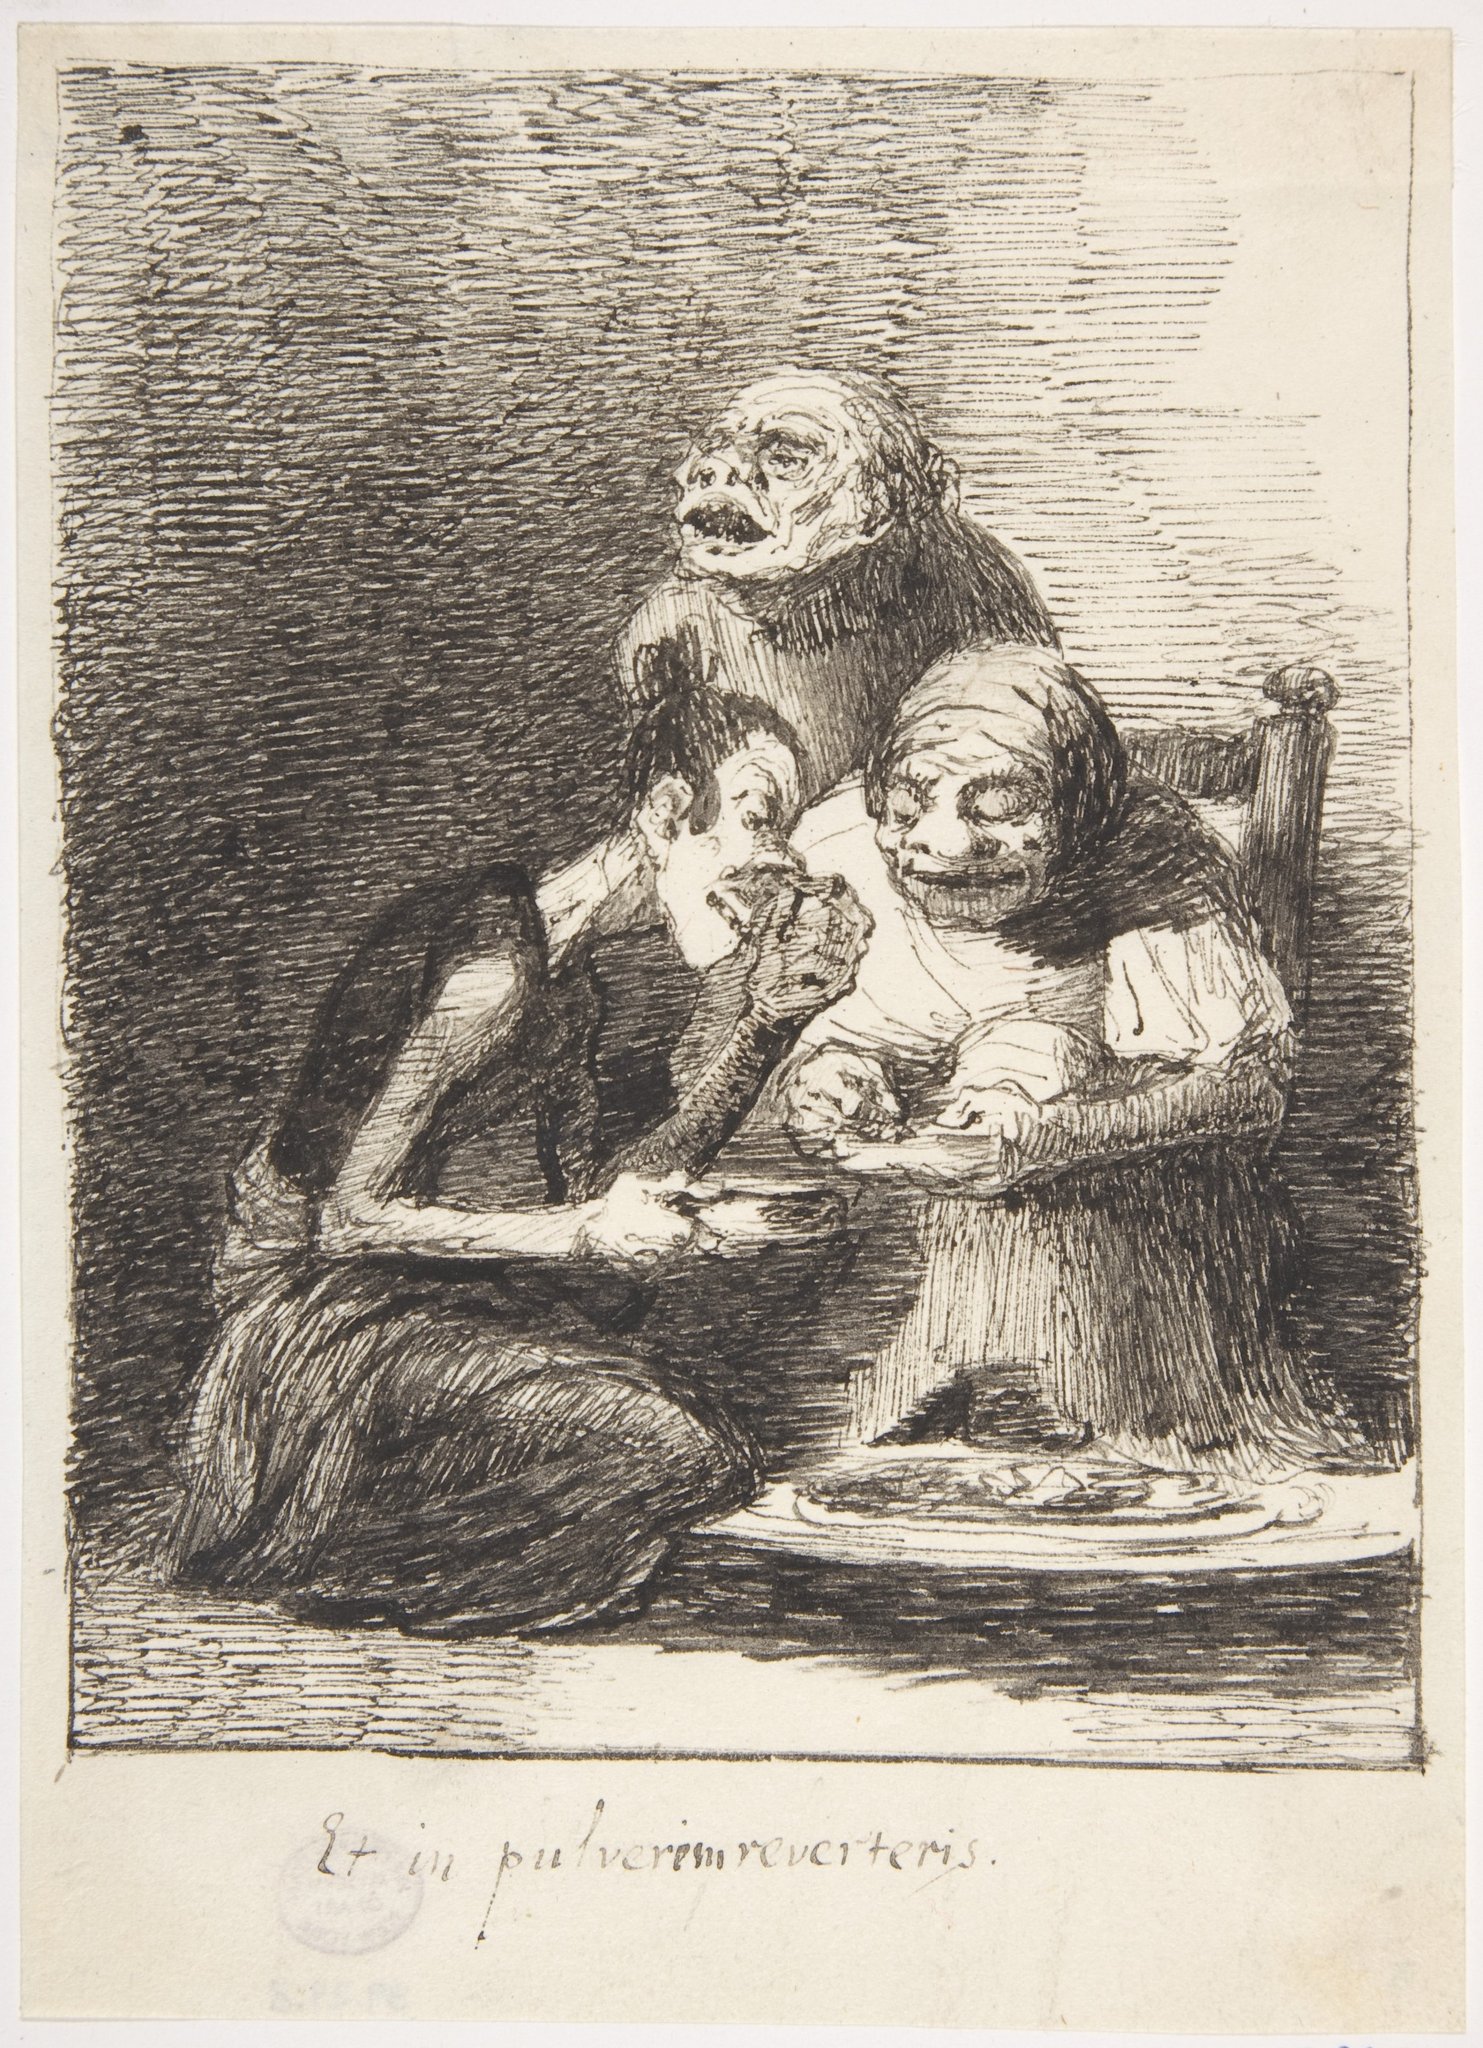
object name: drawing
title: Dust to Dust (Et in pulverem reverteris)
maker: leonardo alenza y nieto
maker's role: artist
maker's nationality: spanish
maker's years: 1807-1845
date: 1807-1845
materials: ink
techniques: brush, pen, wash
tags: women